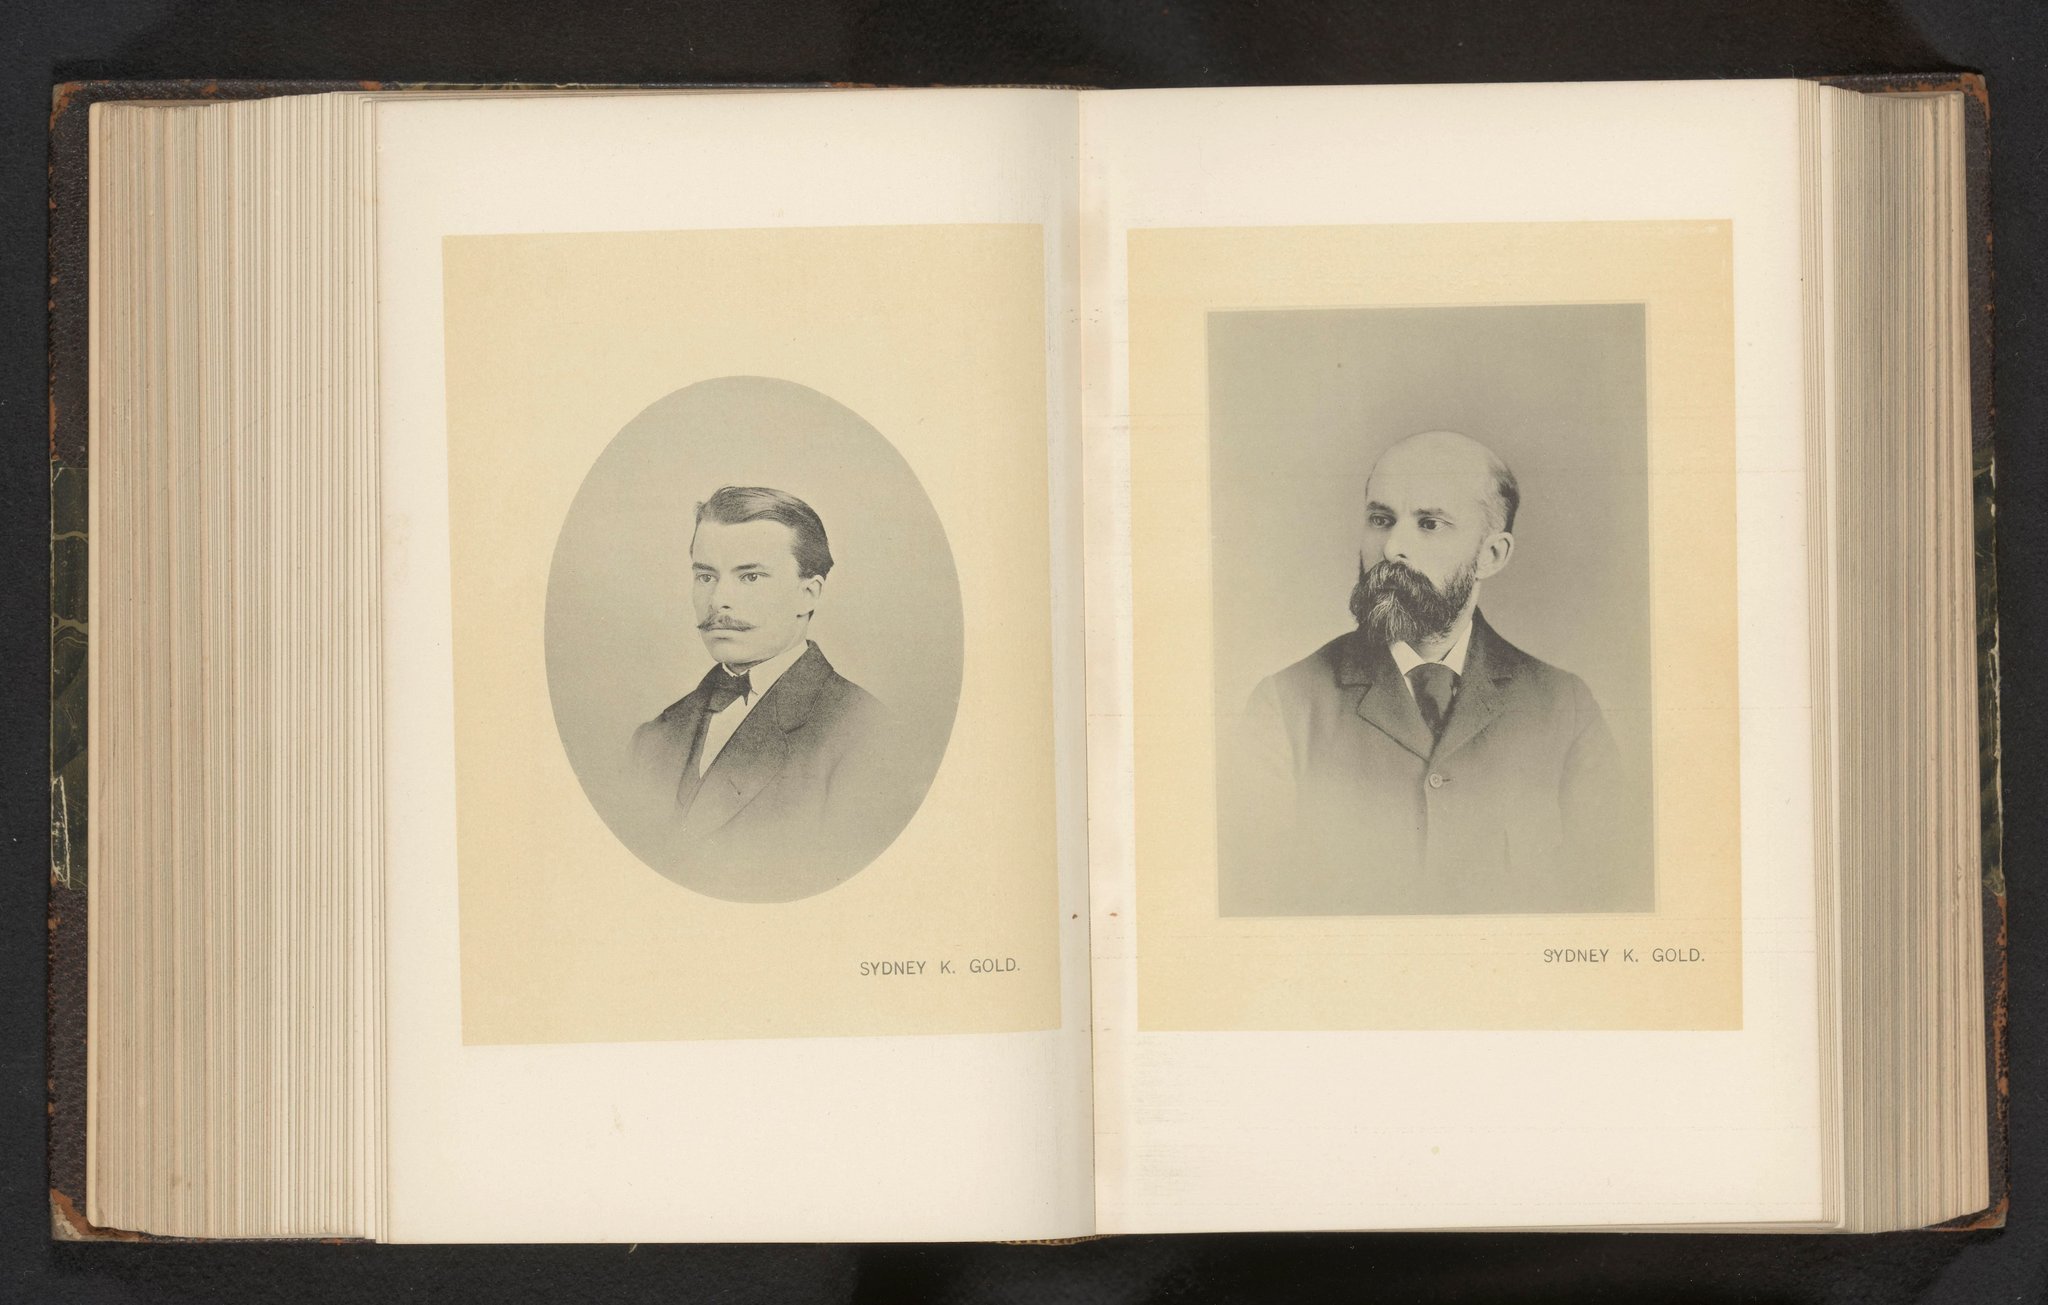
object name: photomechanical print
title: Sydney K. Gold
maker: Anonymous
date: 1869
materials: paper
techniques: photoaquatint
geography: boston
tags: adult man